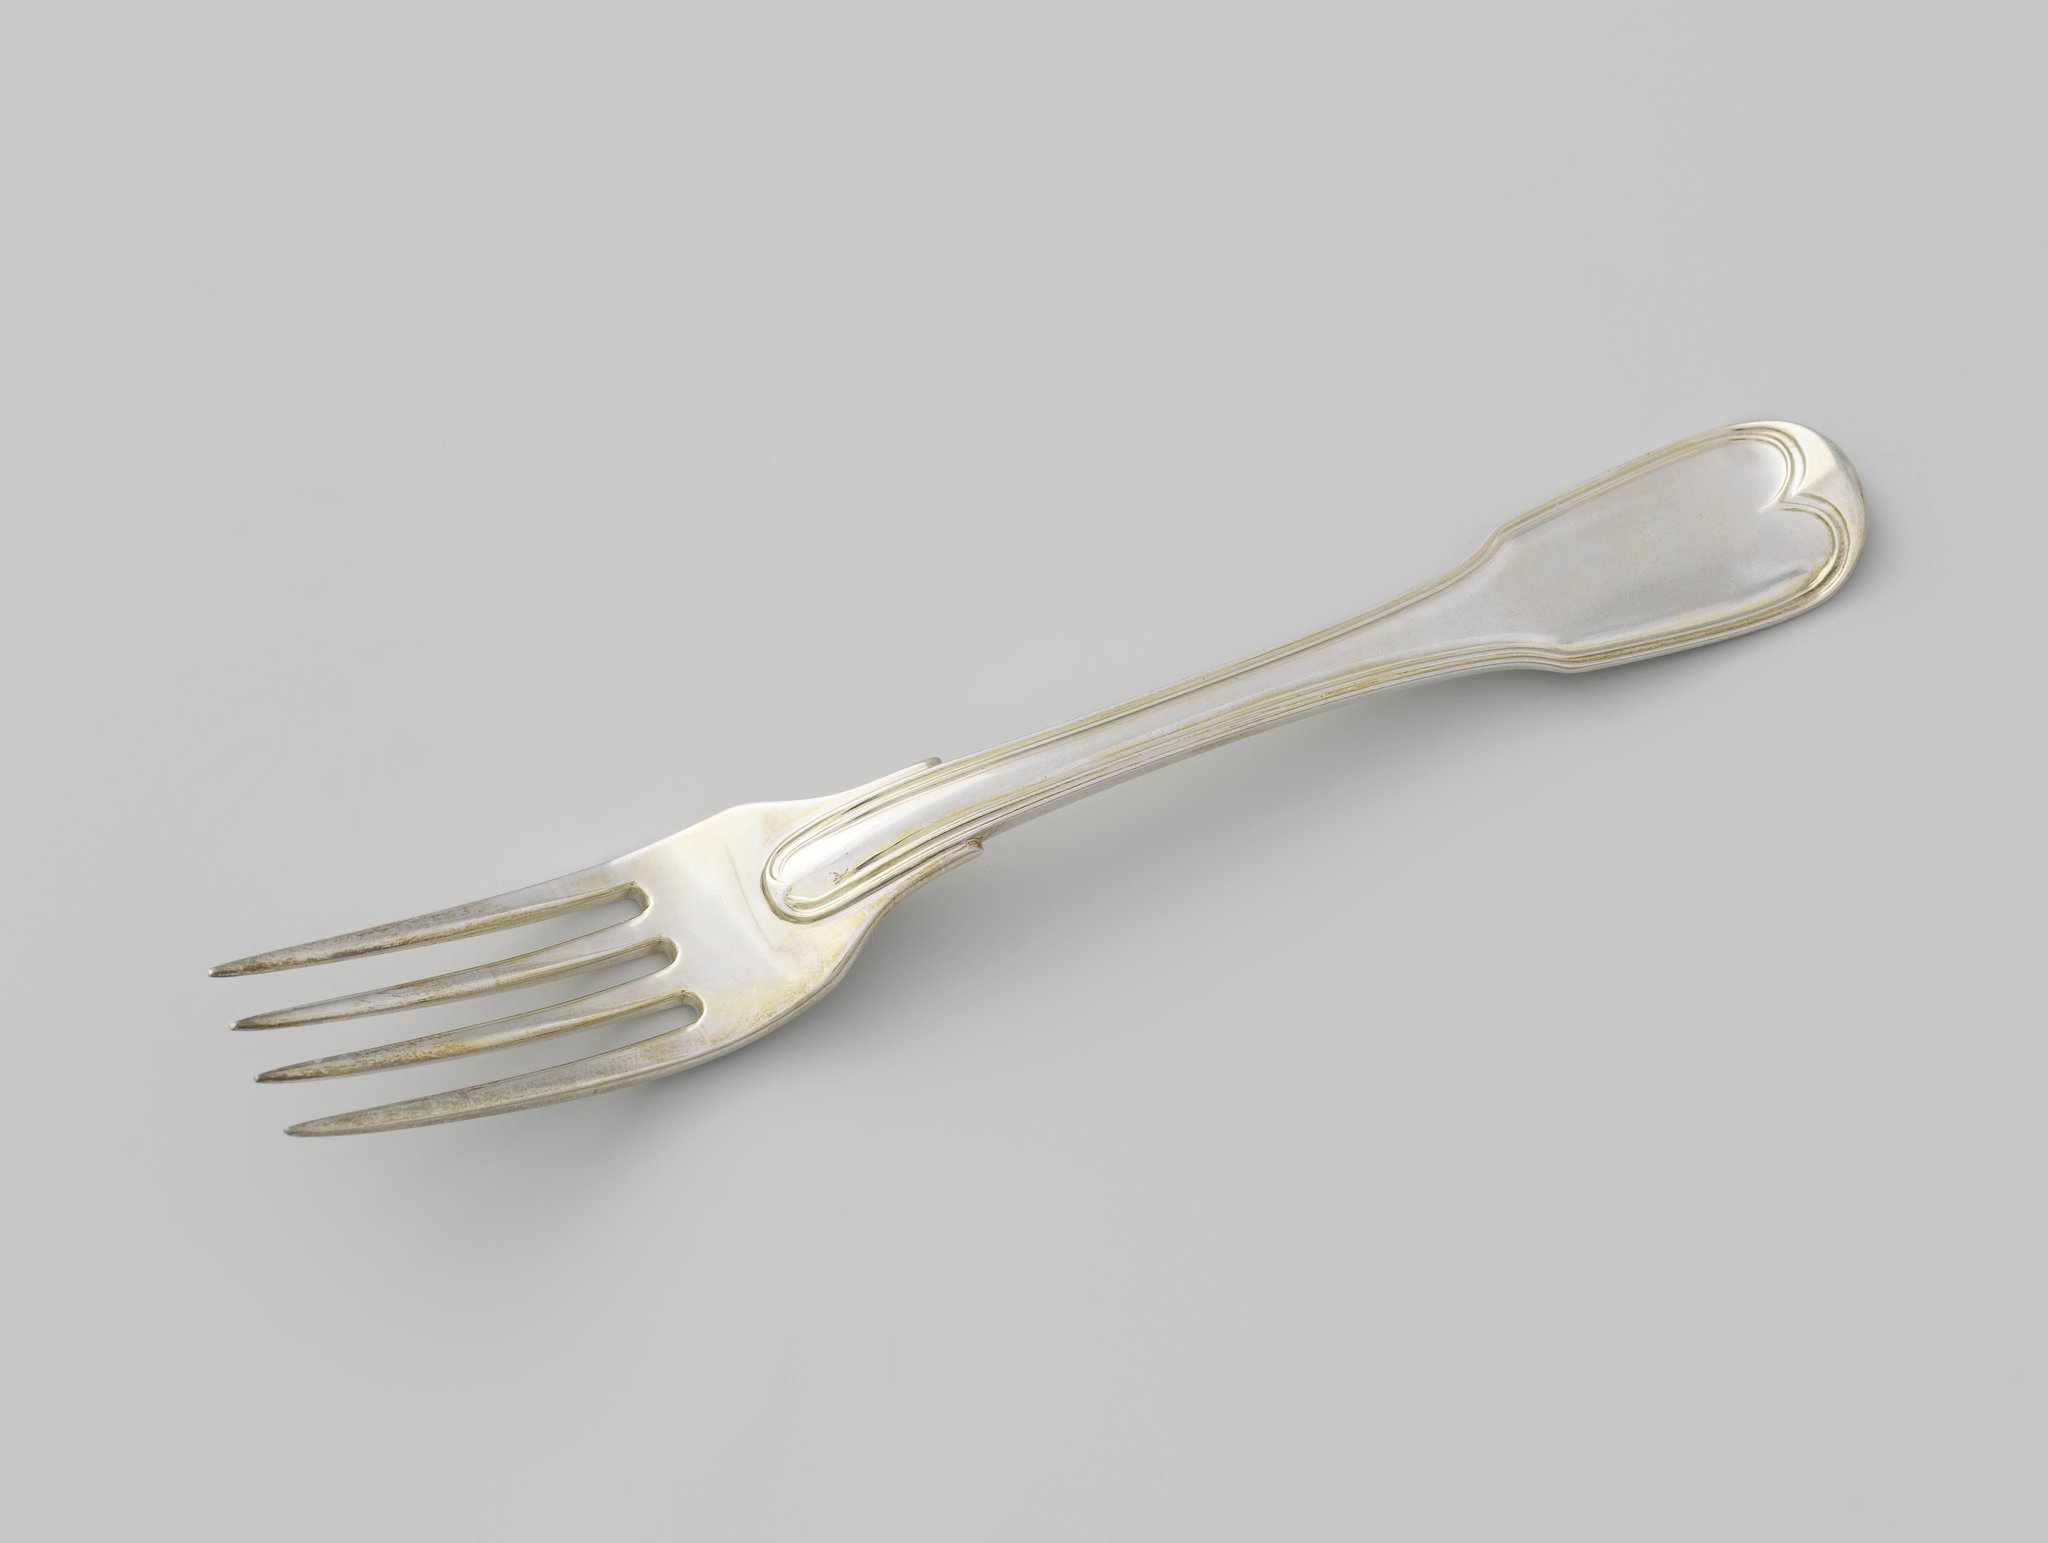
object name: fork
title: Vork met het helmteken Clifford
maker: hendrik helweg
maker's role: silversmith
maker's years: 1802-1858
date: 1832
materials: silver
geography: amsterdam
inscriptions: hallmark: ‘Minervakop met A (keurkamer Amsterdam)’, alloy mark: ‘leeuw 1ste gehalte’, date letter: ‘X (=1806)’, maker's mark: ‘HH onder anker in vierkant’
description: De viertandige vork is aan zowel boven- als onderzijde door middel van enkel lof verbonden met de platte, gebogen steel, die zich verbreedt naar het spatelvormige uiteinde. Boven- en onderzijde van de steel worden omgeven door een dubbele filetrand, die bij het uiteinde ingezwenkt is. Op de onderzijde van de spatel is het helmteken Clifford gegraveerd.